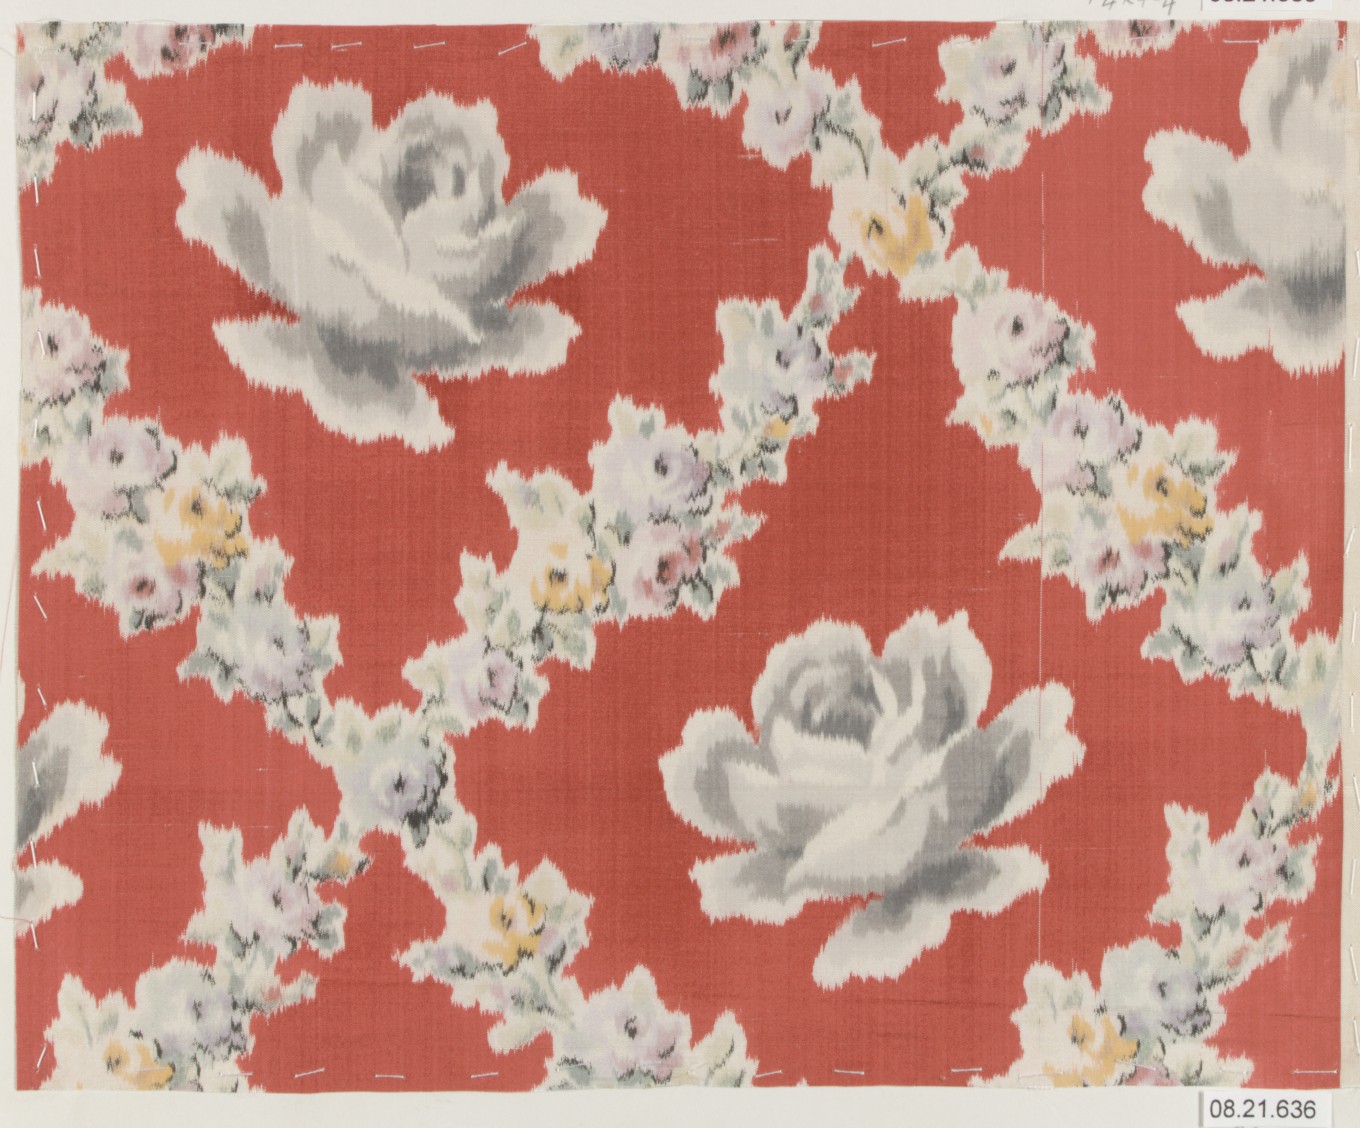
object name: textile sample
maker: Anonymous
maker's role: designer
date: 1900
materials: silk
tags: roses